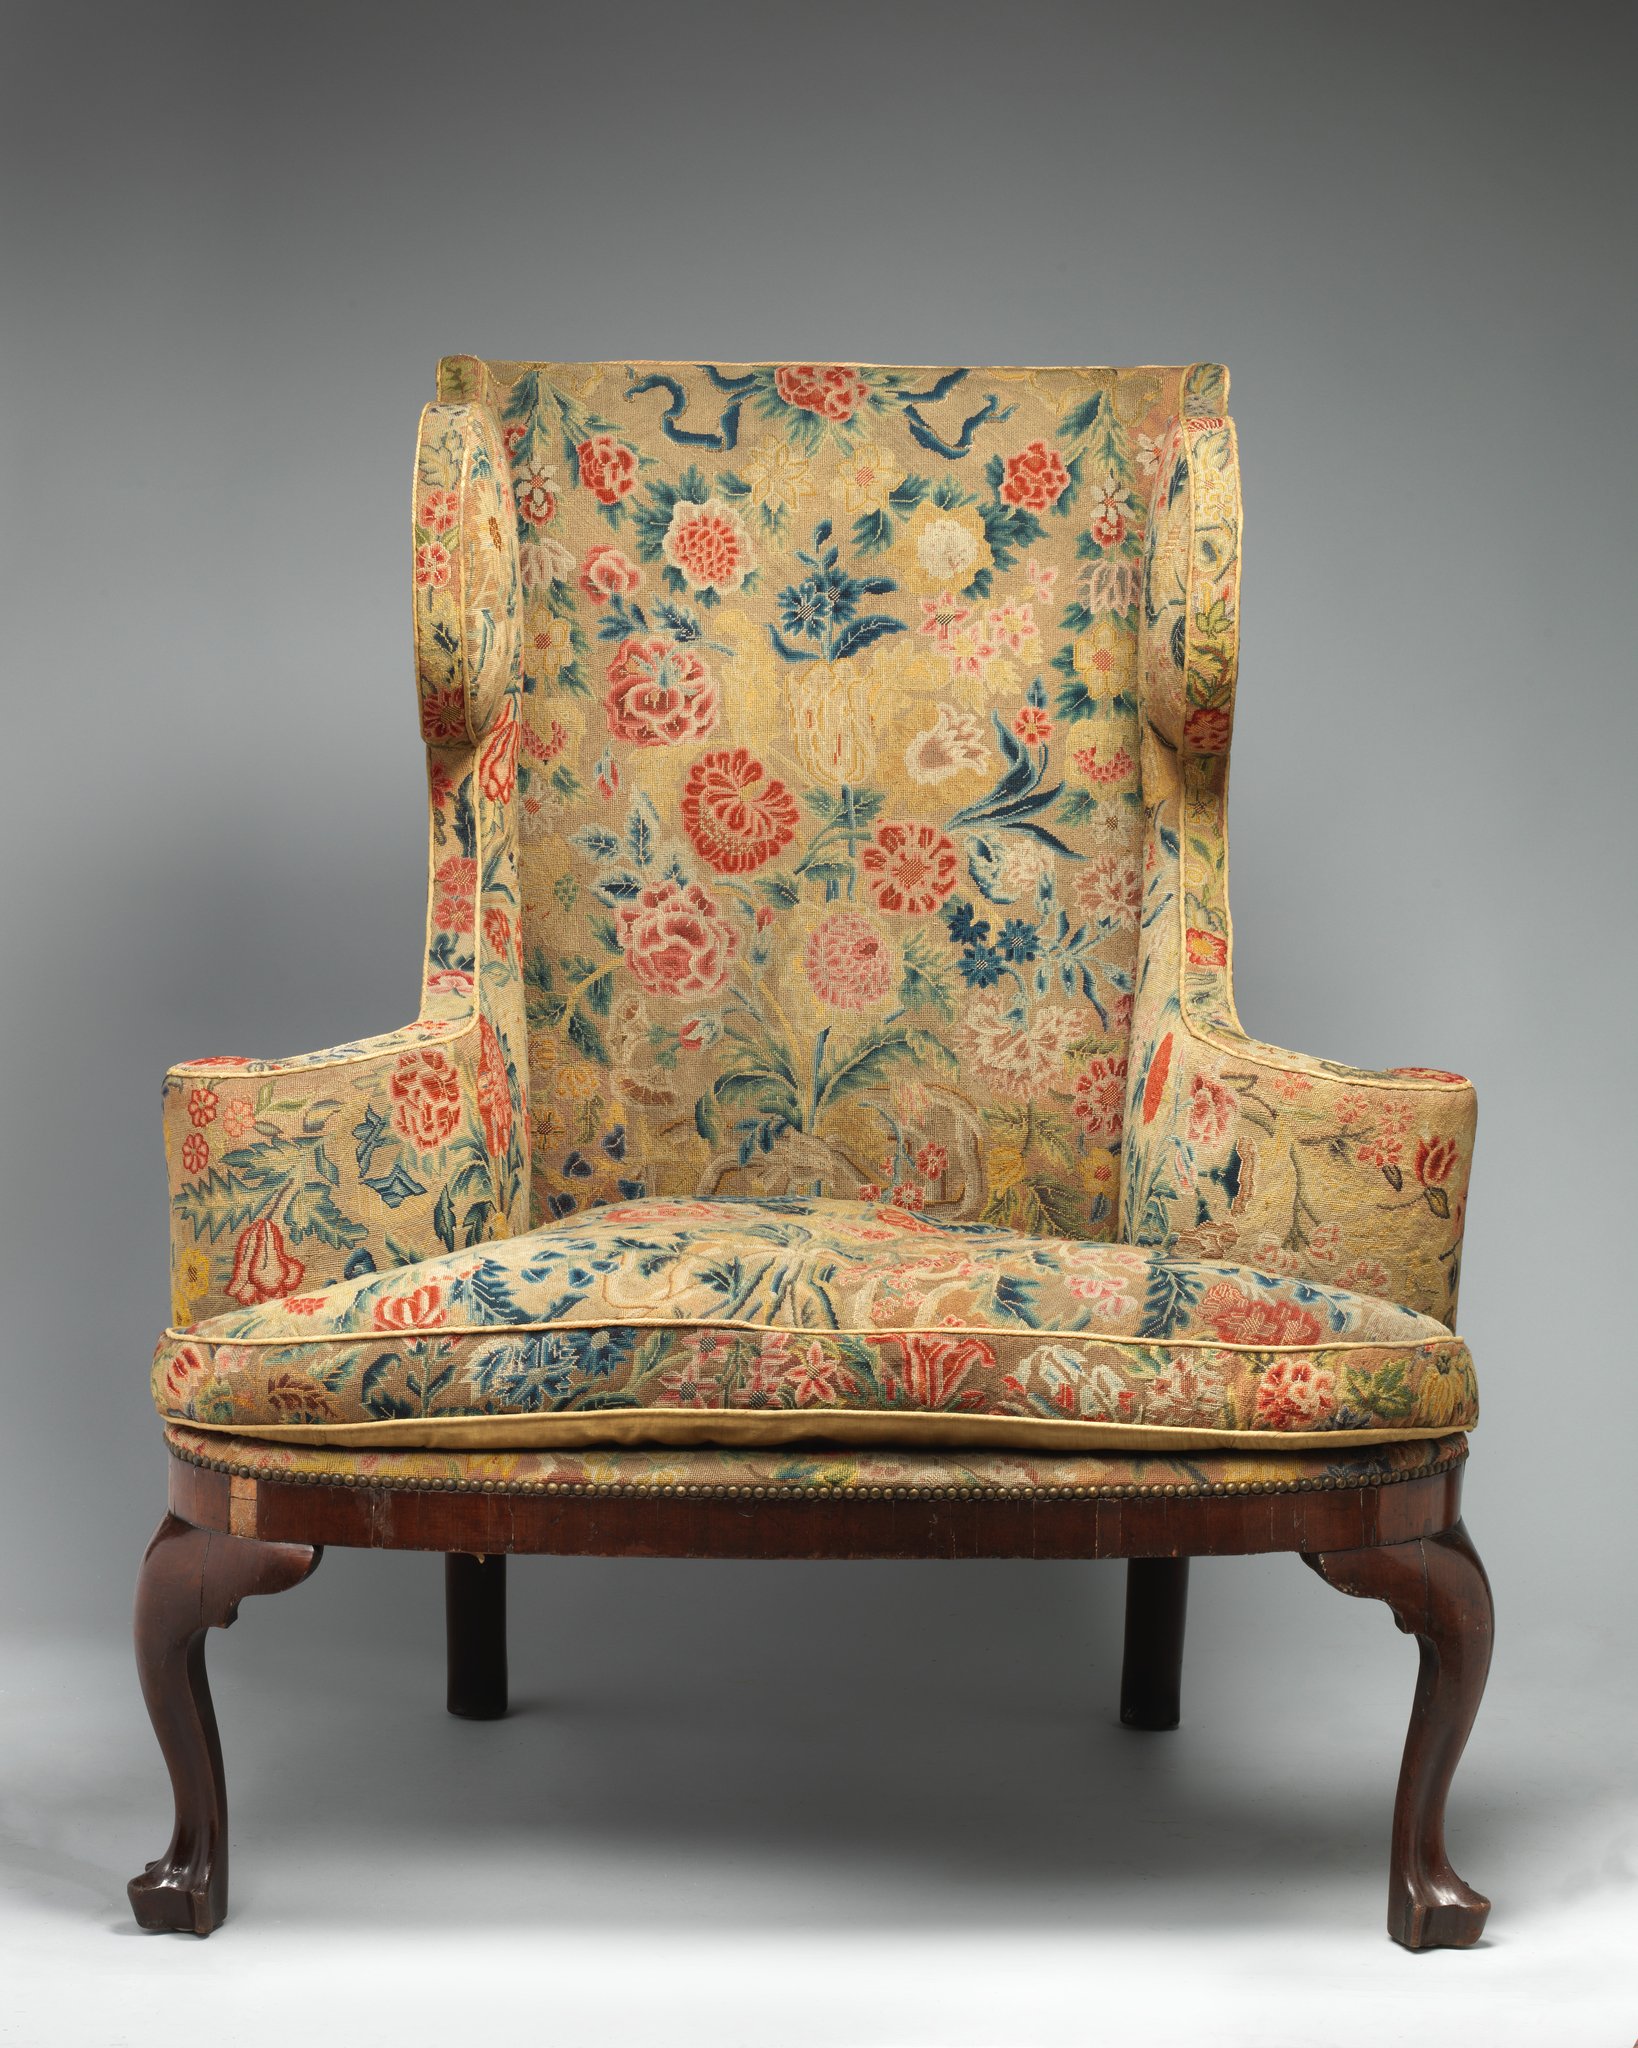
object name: wing chair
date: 1725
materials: wood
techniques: veneering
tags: flowers